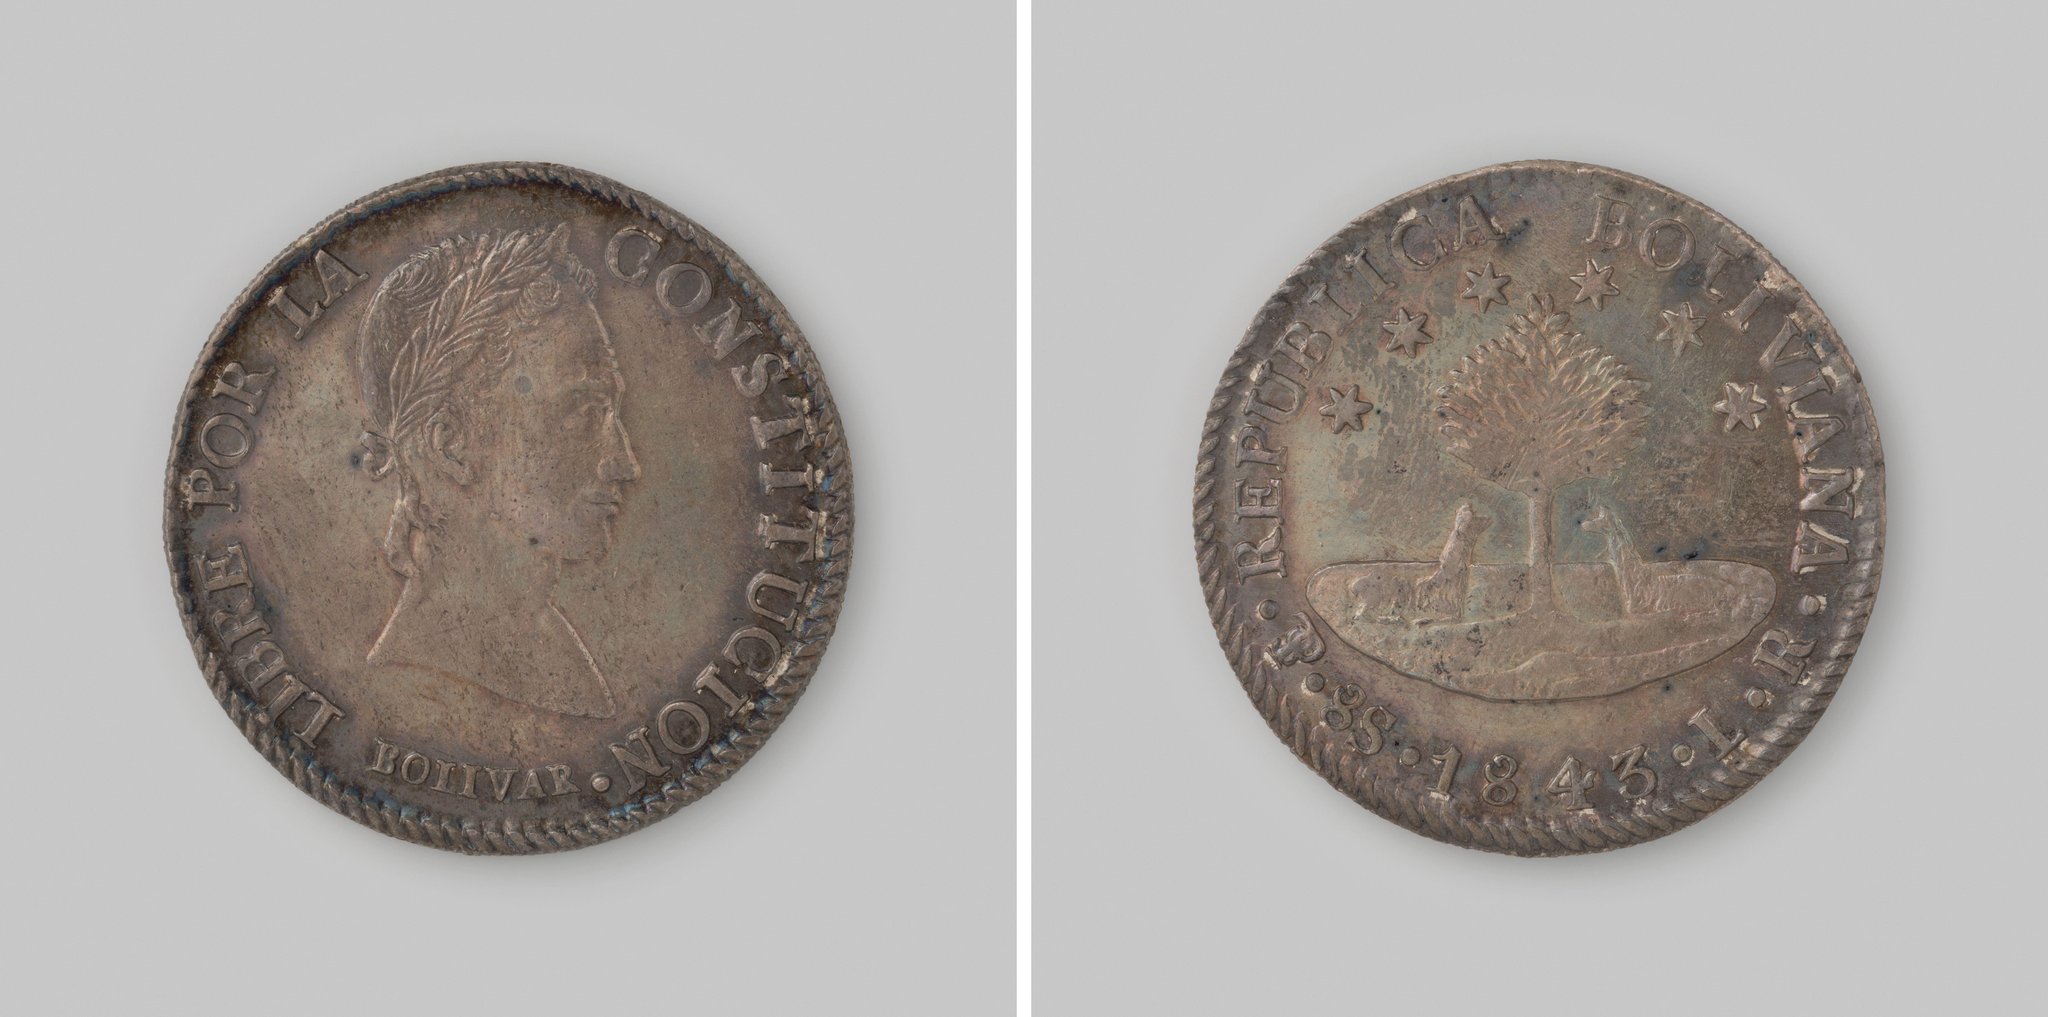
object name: coin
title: Bolivia, acht soles, 1843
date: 1843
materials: silver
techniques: striking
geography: potosi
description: Zilveren munt uit ruw muntplaatje. Voorzijde: gelauwerd hoofd van Bolivar naar rechts. Keerzijde: in landschap staande boom, waarboven zes sterren. met links en rechts onder de boom een lama. Jaartal onderaan. Links daarvan aanduiding muntplaats: Potosi en waarde-aanduiding: 8 S. Kartelrand.